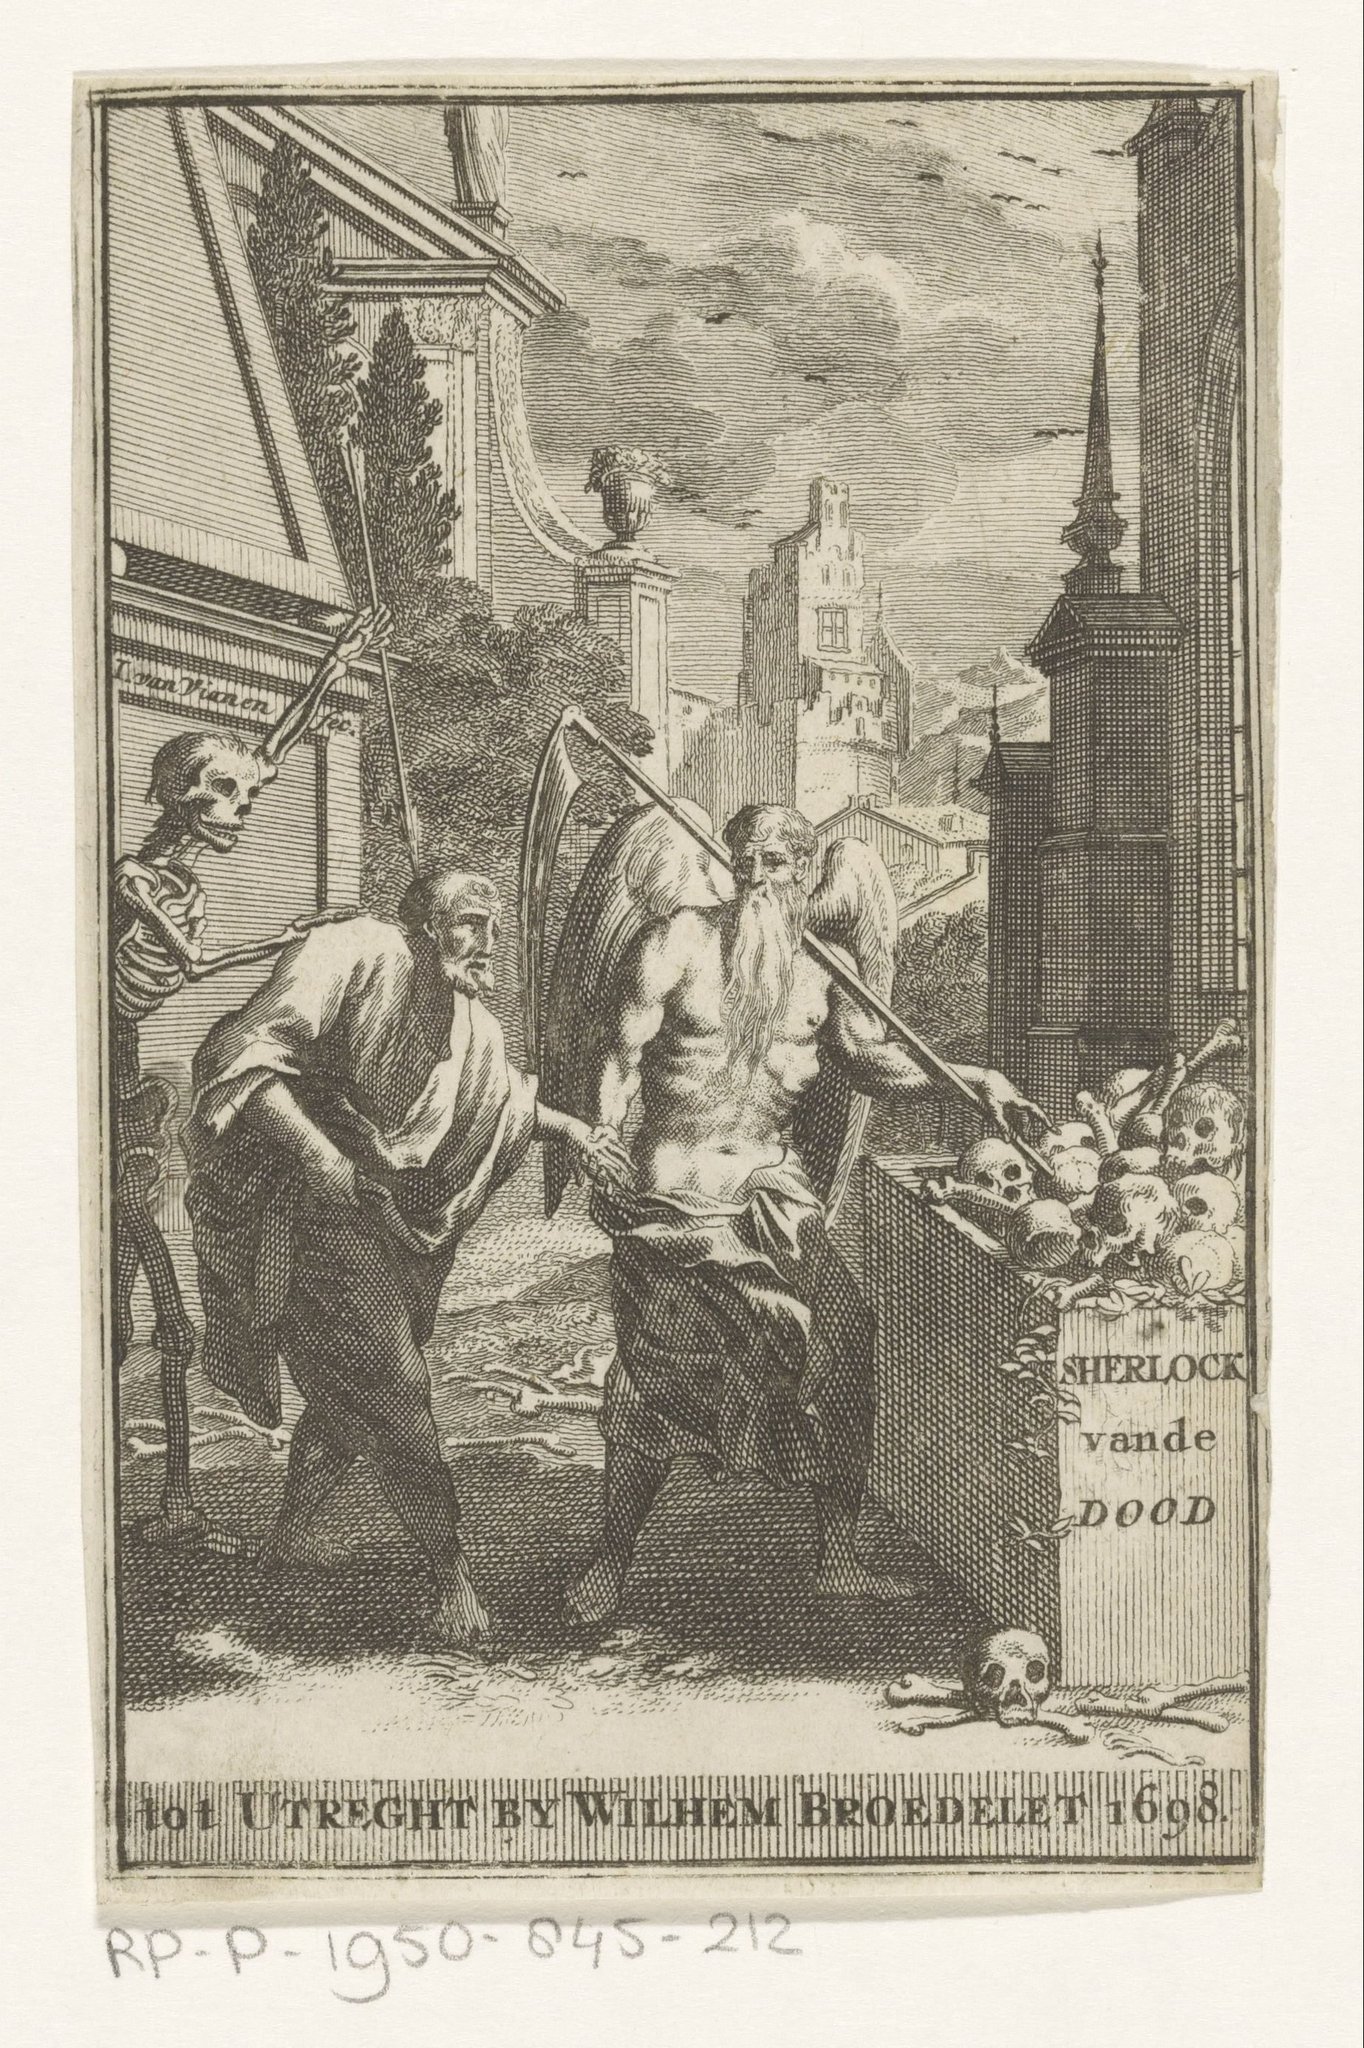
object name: print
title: Sherlock van de dood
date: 1698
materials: paper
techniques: engraving, etching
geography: utrecht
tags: death as skeleton, old man, father time, man with wings and scythe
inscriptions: collector's mark: Lugt 2228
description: Prent is mogelijk een titelpagina of boekillustratie. Prent afkomstig uit een plakalbum met titelprenten, ornamenten etc. op blauw papier in 1983 uit elkaar gehaald. Volgens een notitie op verso zat de prent op p. 212 van dit album.